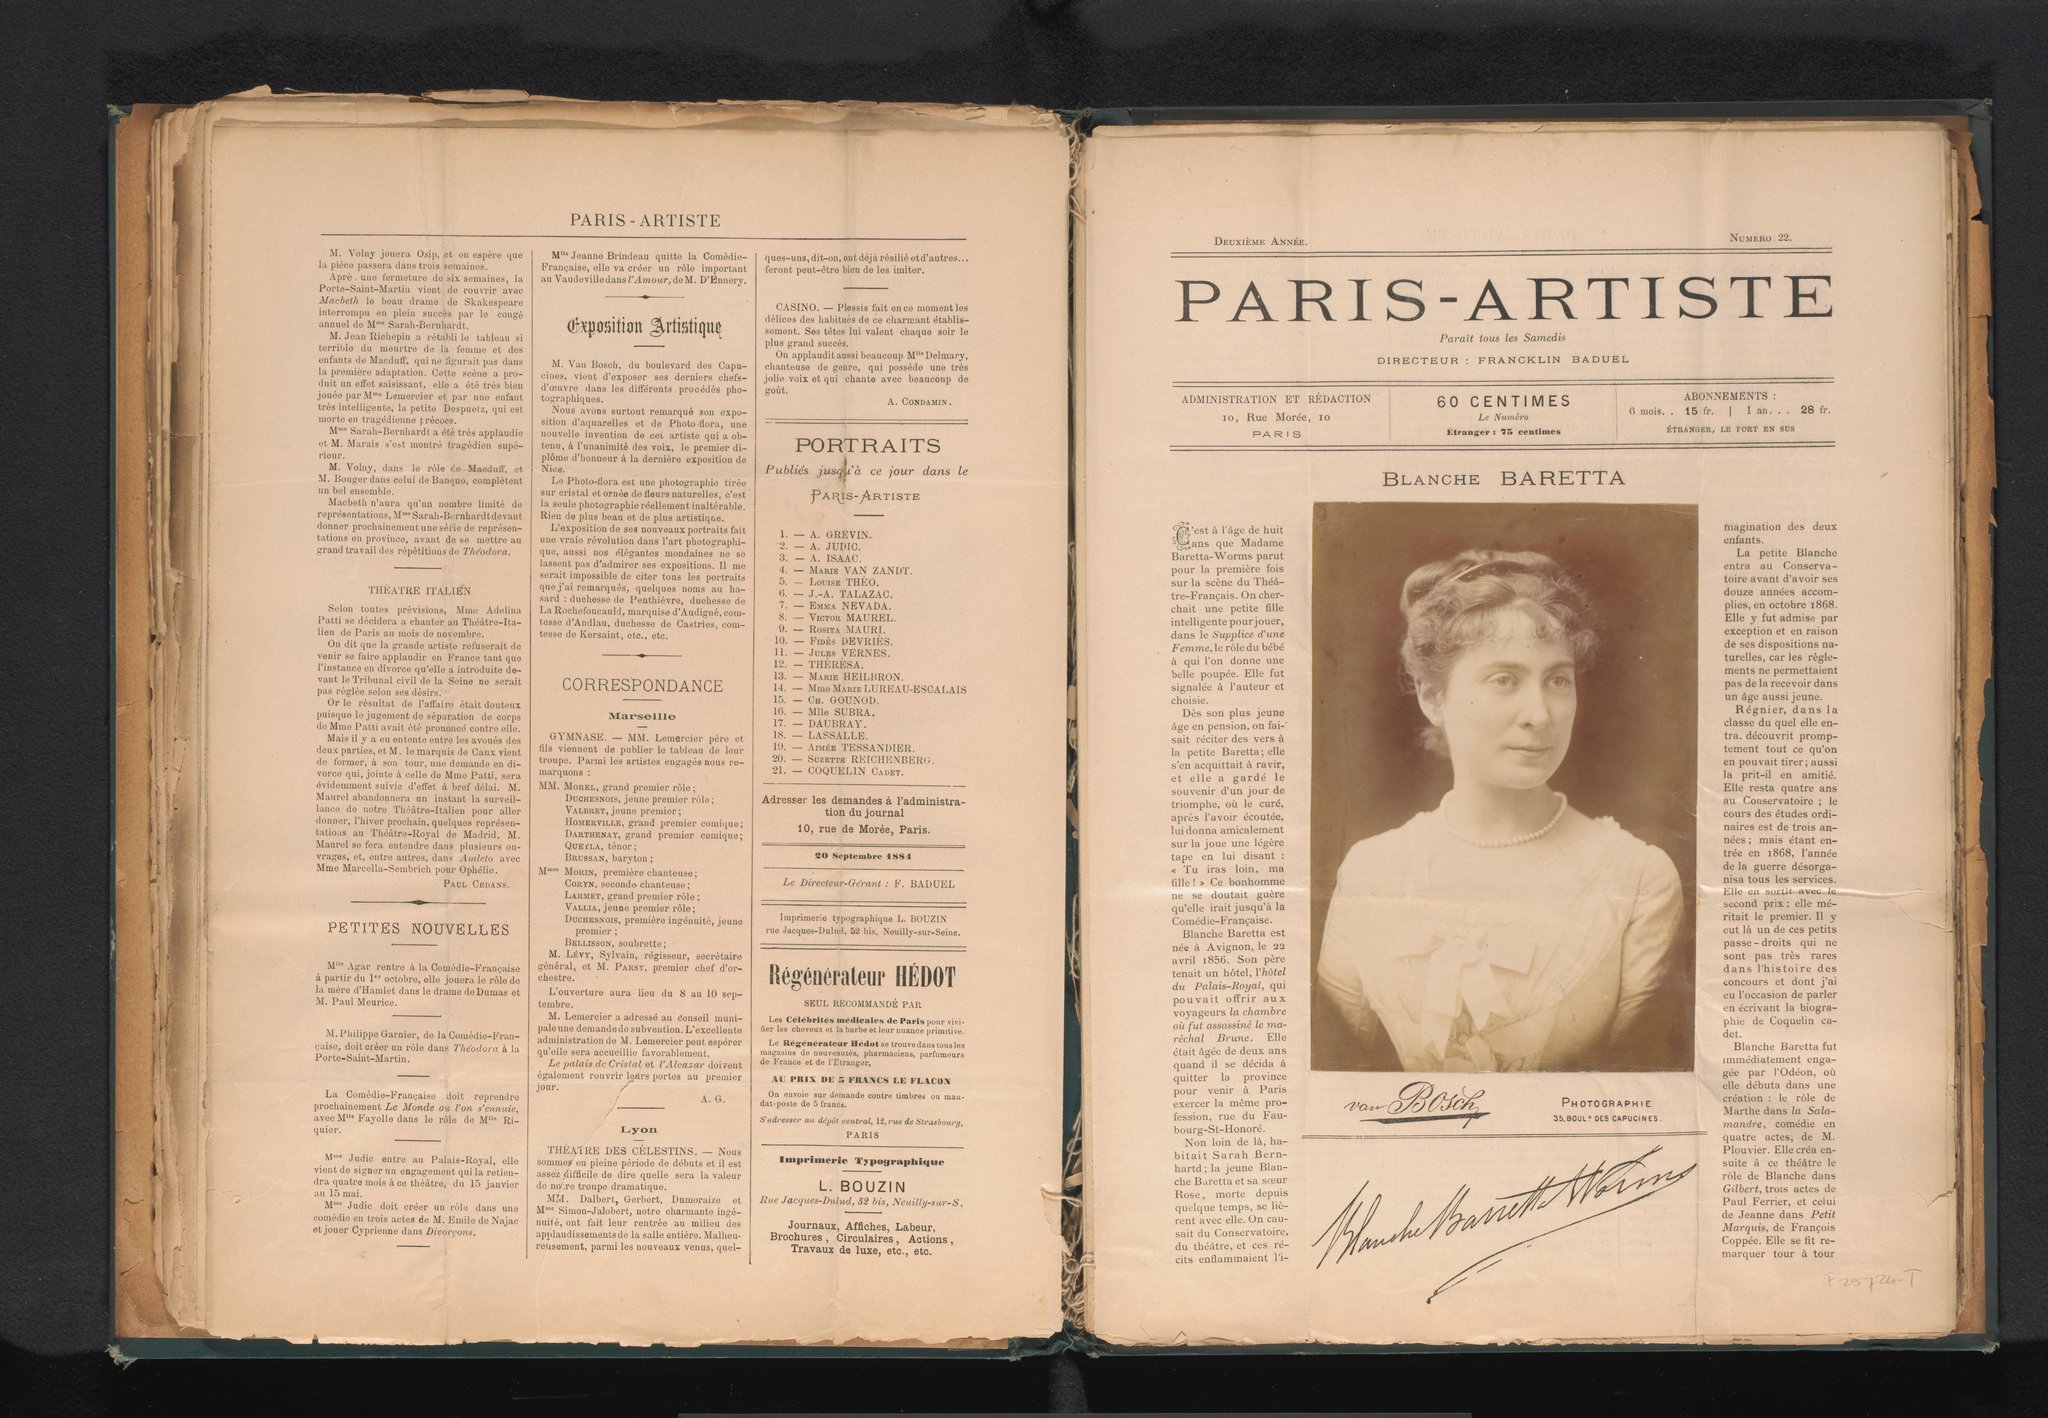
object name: photograph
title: Portret van Blanche Baretta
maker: otto van bosch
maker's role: fotograaf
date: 1875-1884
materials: photographic support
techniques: albumen print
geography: paris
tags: historical persons - bb - woman, portrait of actor, actress